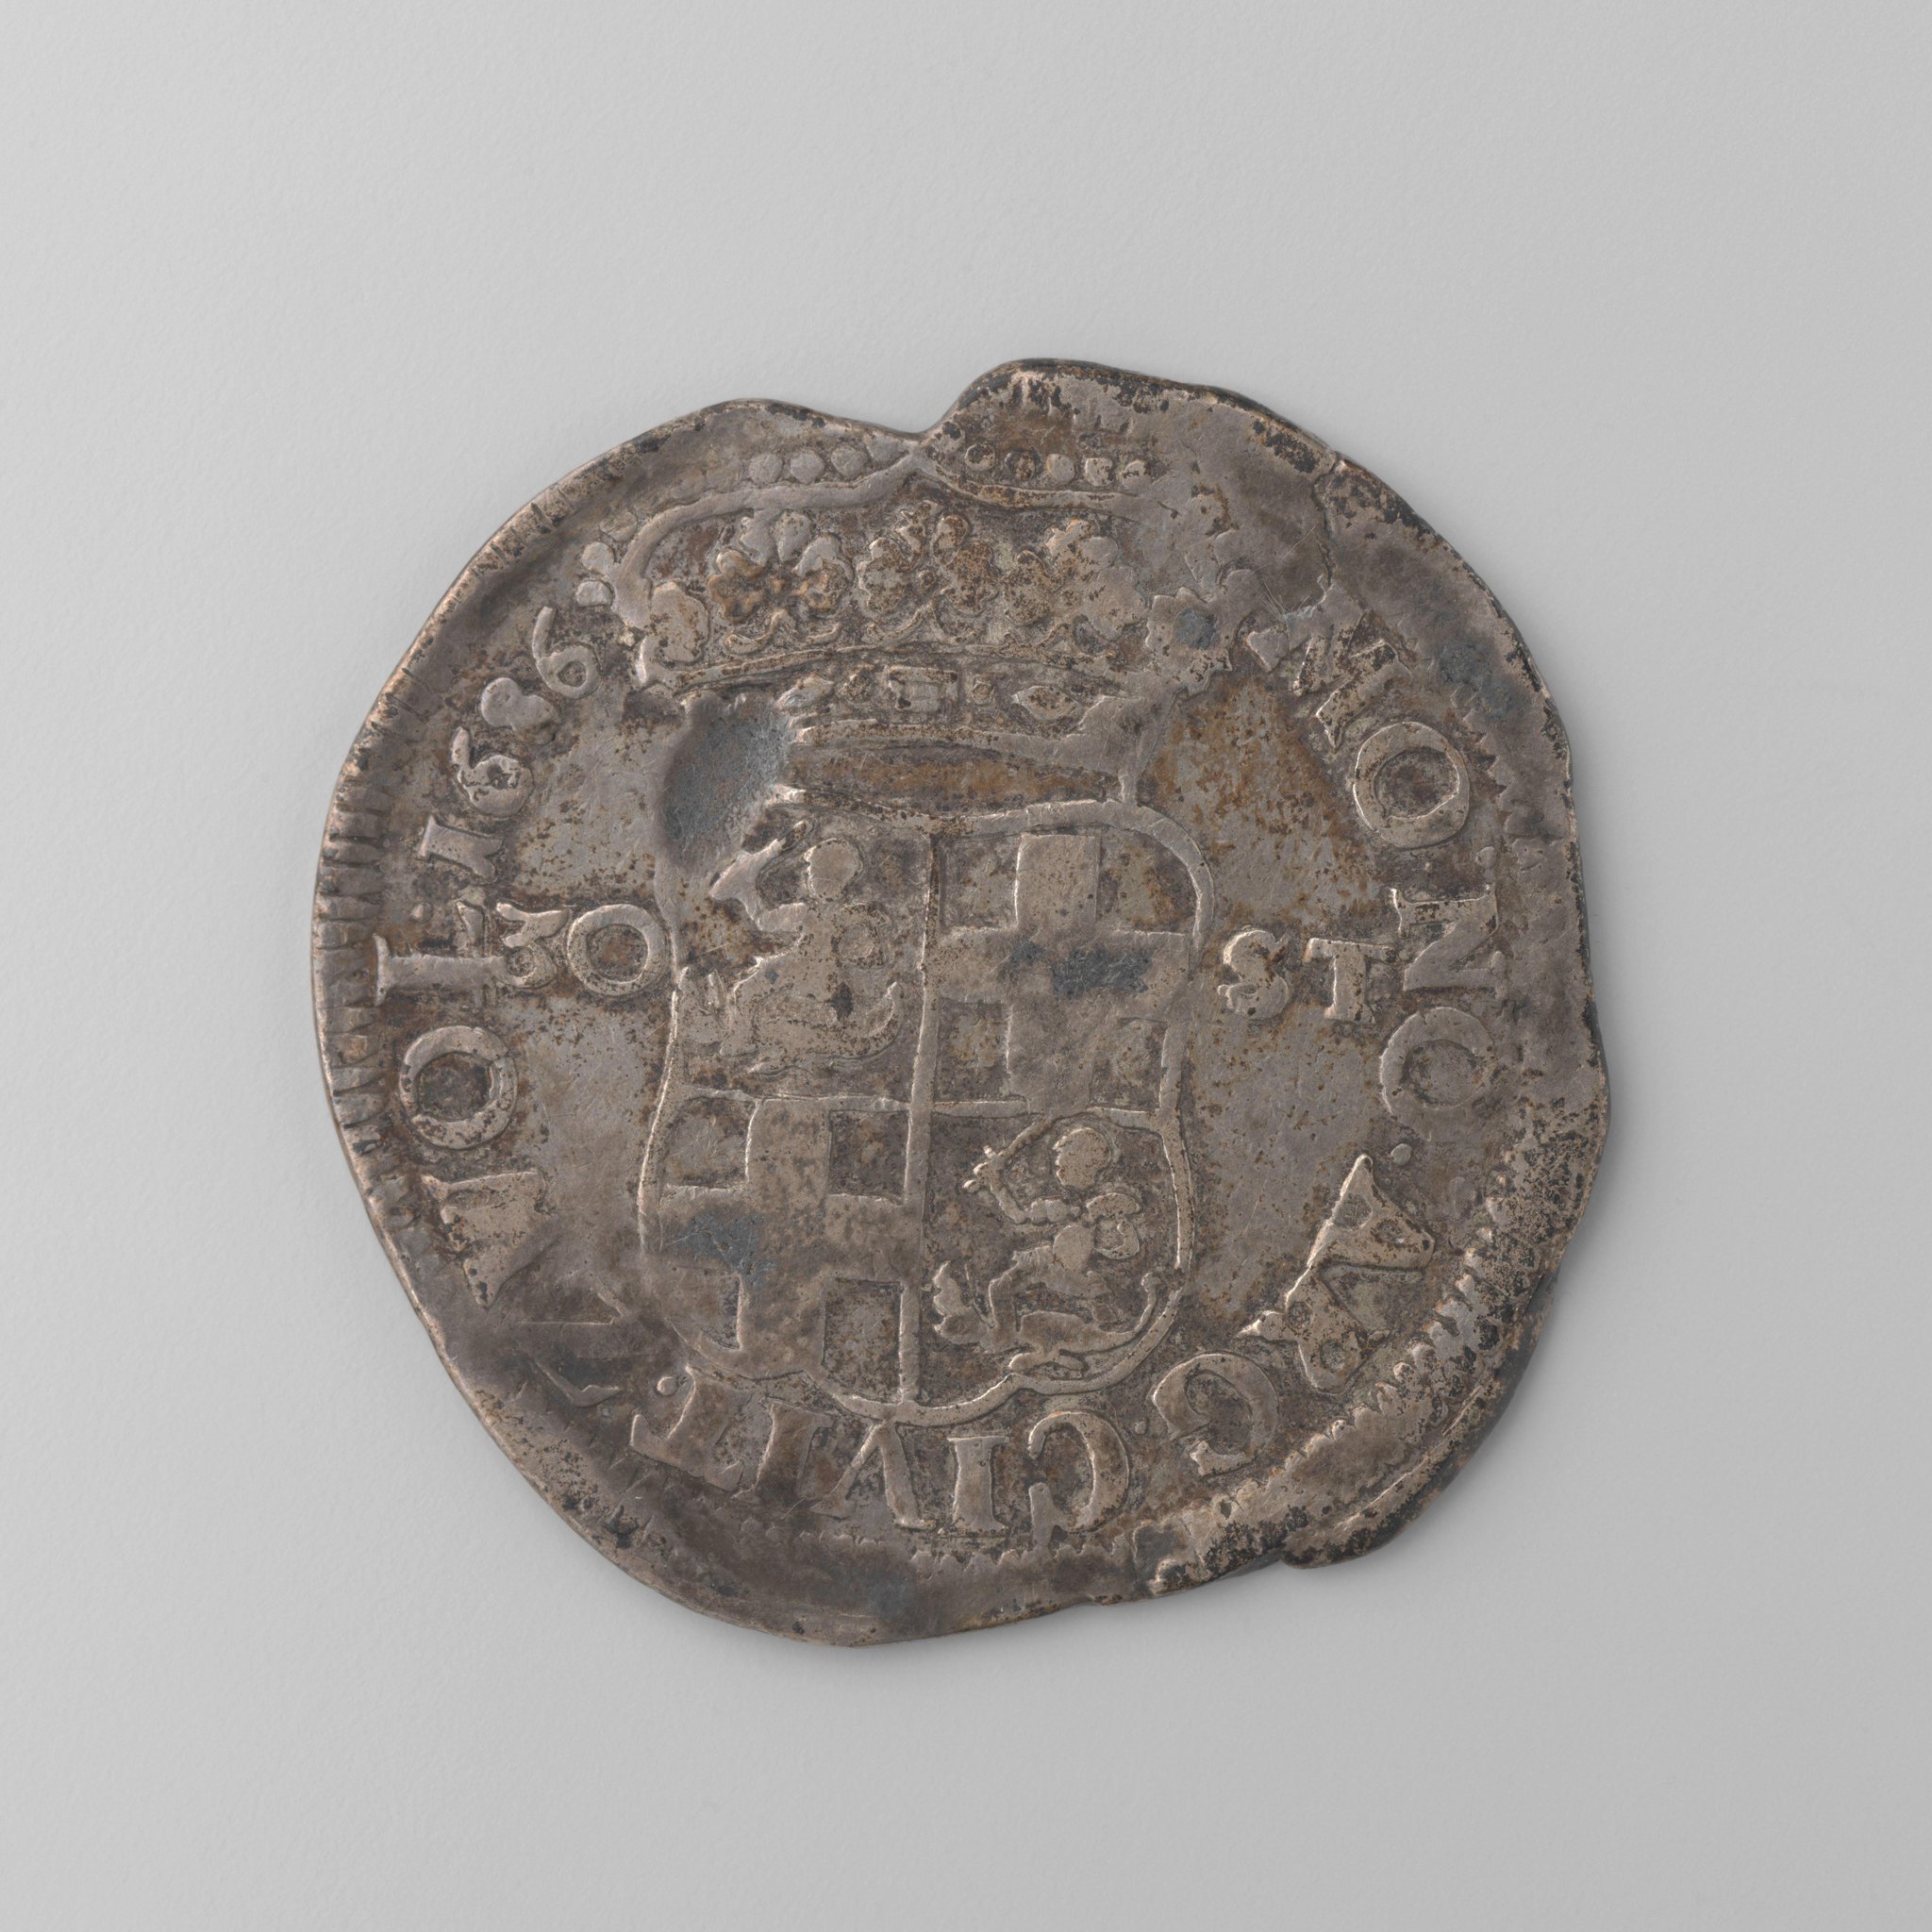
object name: coin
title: Zwolse daalder, 1686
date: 1686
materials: silver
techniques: striking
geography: zwolle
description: Zilveren munt. Voorzijde: tussen waarde-aanduiding 30 ST gekroond gevierendeeld Zwols wapenschild. Jaartal in omschrift. Keerzijde: staande geharnaste man met Zwols wapenschild aan lint.